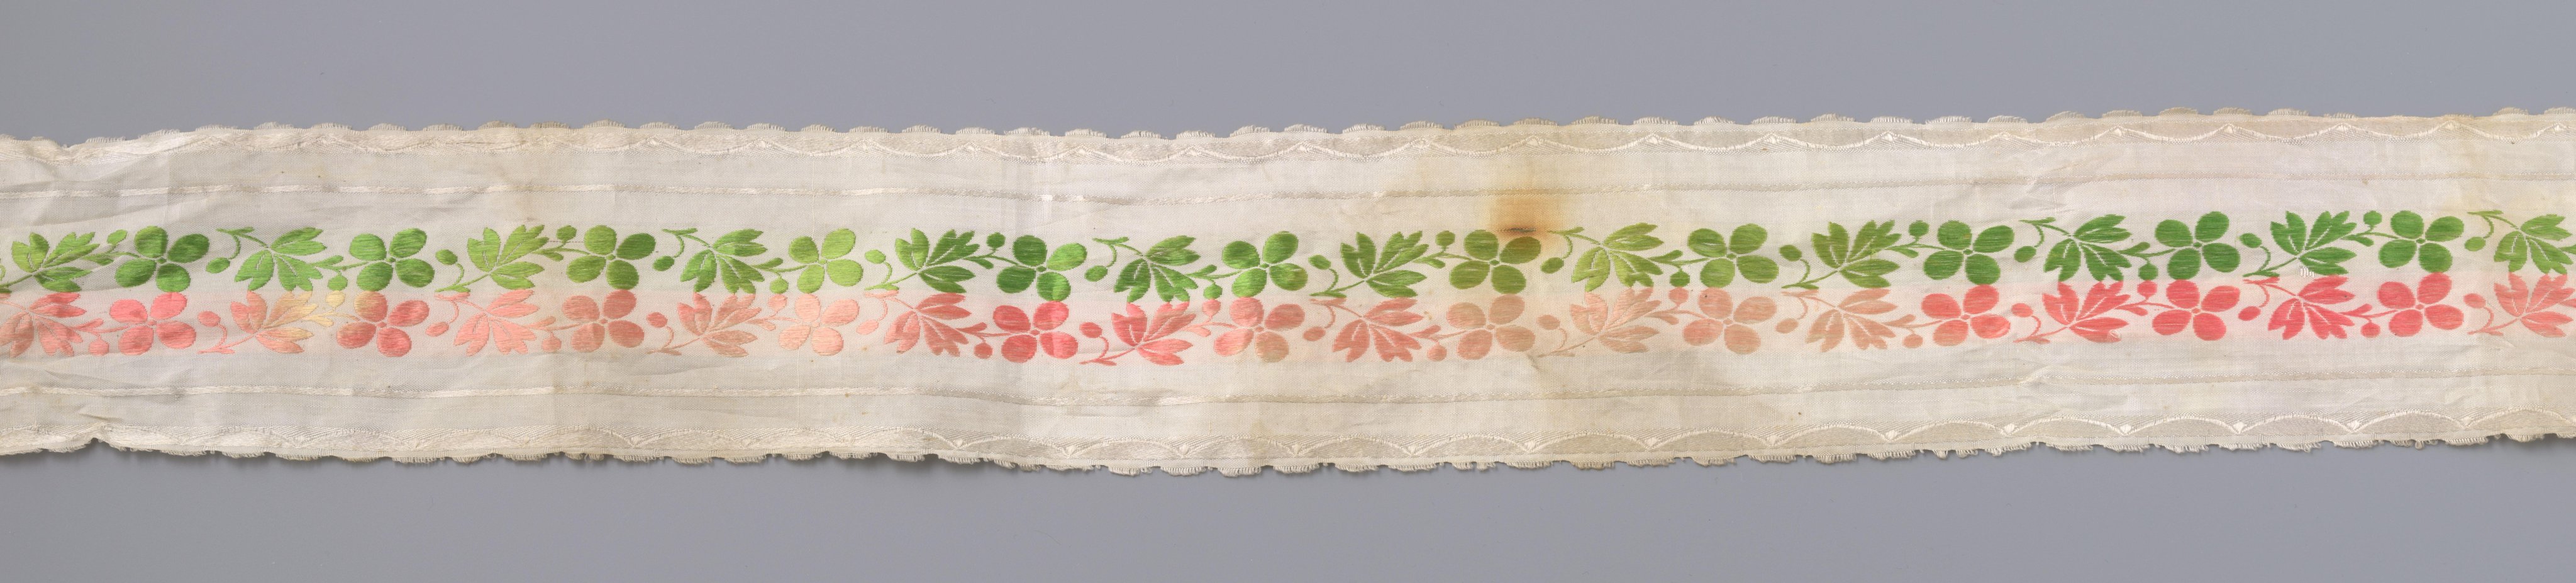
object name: ribbon material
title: Lint van gebrocheerde zijde met een roomkleurige ondergrond waarop over de gehele lengte een naast elkaar gelegen roze en groene bloem- en bladrank zijn aangebracht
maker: Anonymous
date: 1800-1815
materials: silk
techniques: brocade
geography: western europe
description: Lint van gebrocheerde zijde met een roomkleurige ondergrond waarop over de gehele lengte een naast elkaar gelegen roze en groene bloem- en bladrank zijn aangebracht. De randen zijn geschulpt.